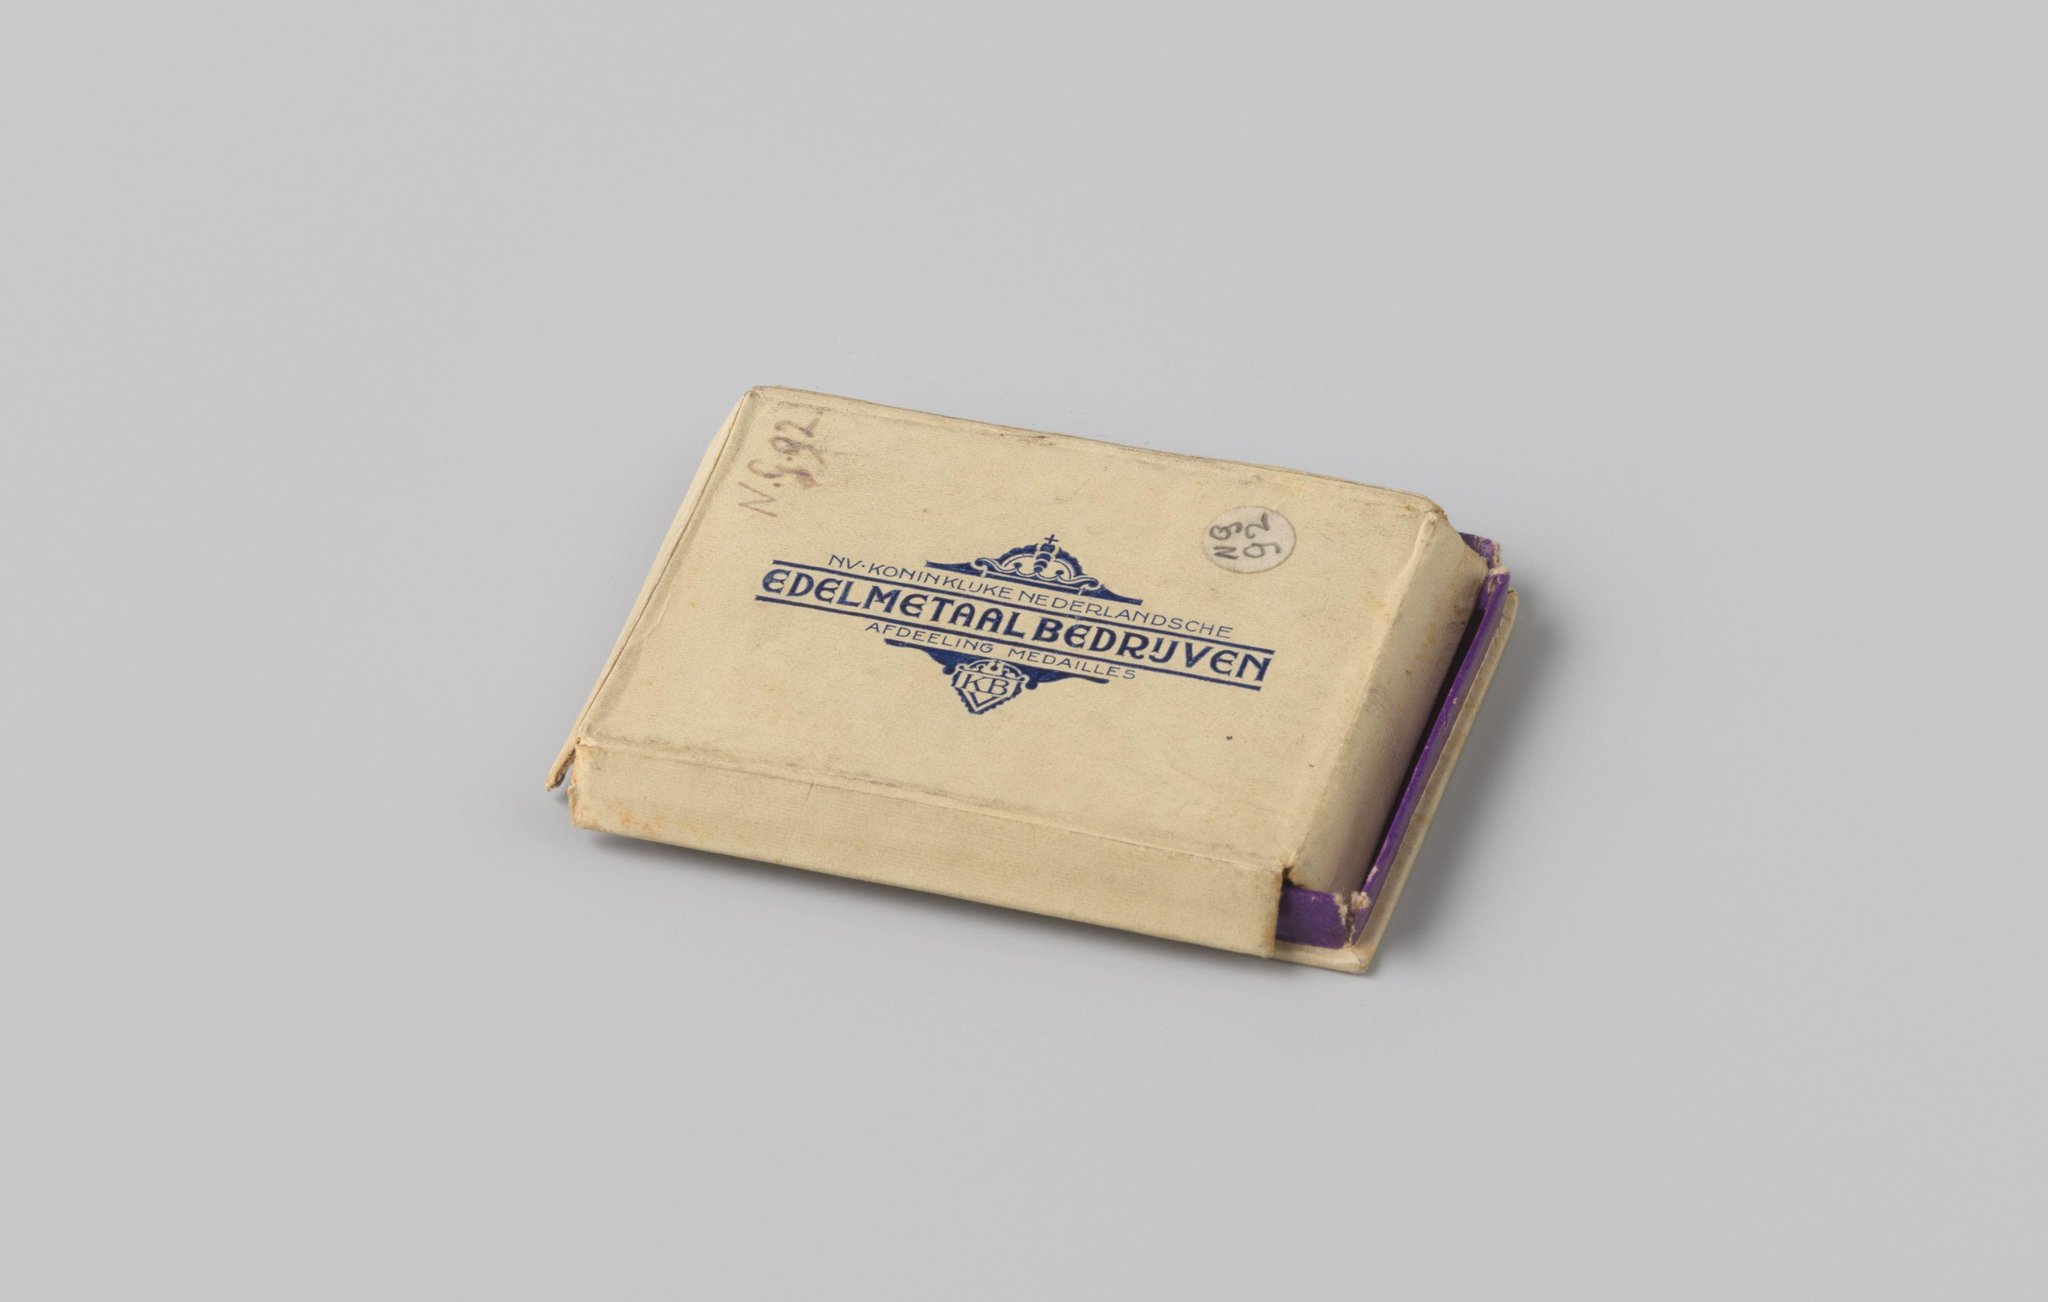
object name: box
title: Doosje behorend bij een plaquette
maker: bernard richters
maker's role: print maker, sculptor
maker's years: 1888-1966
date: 1925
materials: cardboard, velvet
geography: voorschoten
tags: beurs van berlage, stadhuis van amsterdam (14e eeuw-1652)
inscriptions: date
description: Kartonnen doosje behorend bij een plaquette. Op de deksel van het doosje staat 'N.V. KONINKLIJKE NEDERLANDSCHE EDELMETAALBEDRIJVEN AFDEELING MEDIALLES KB'. Binnenzijde bestaat uit paars fluweel.